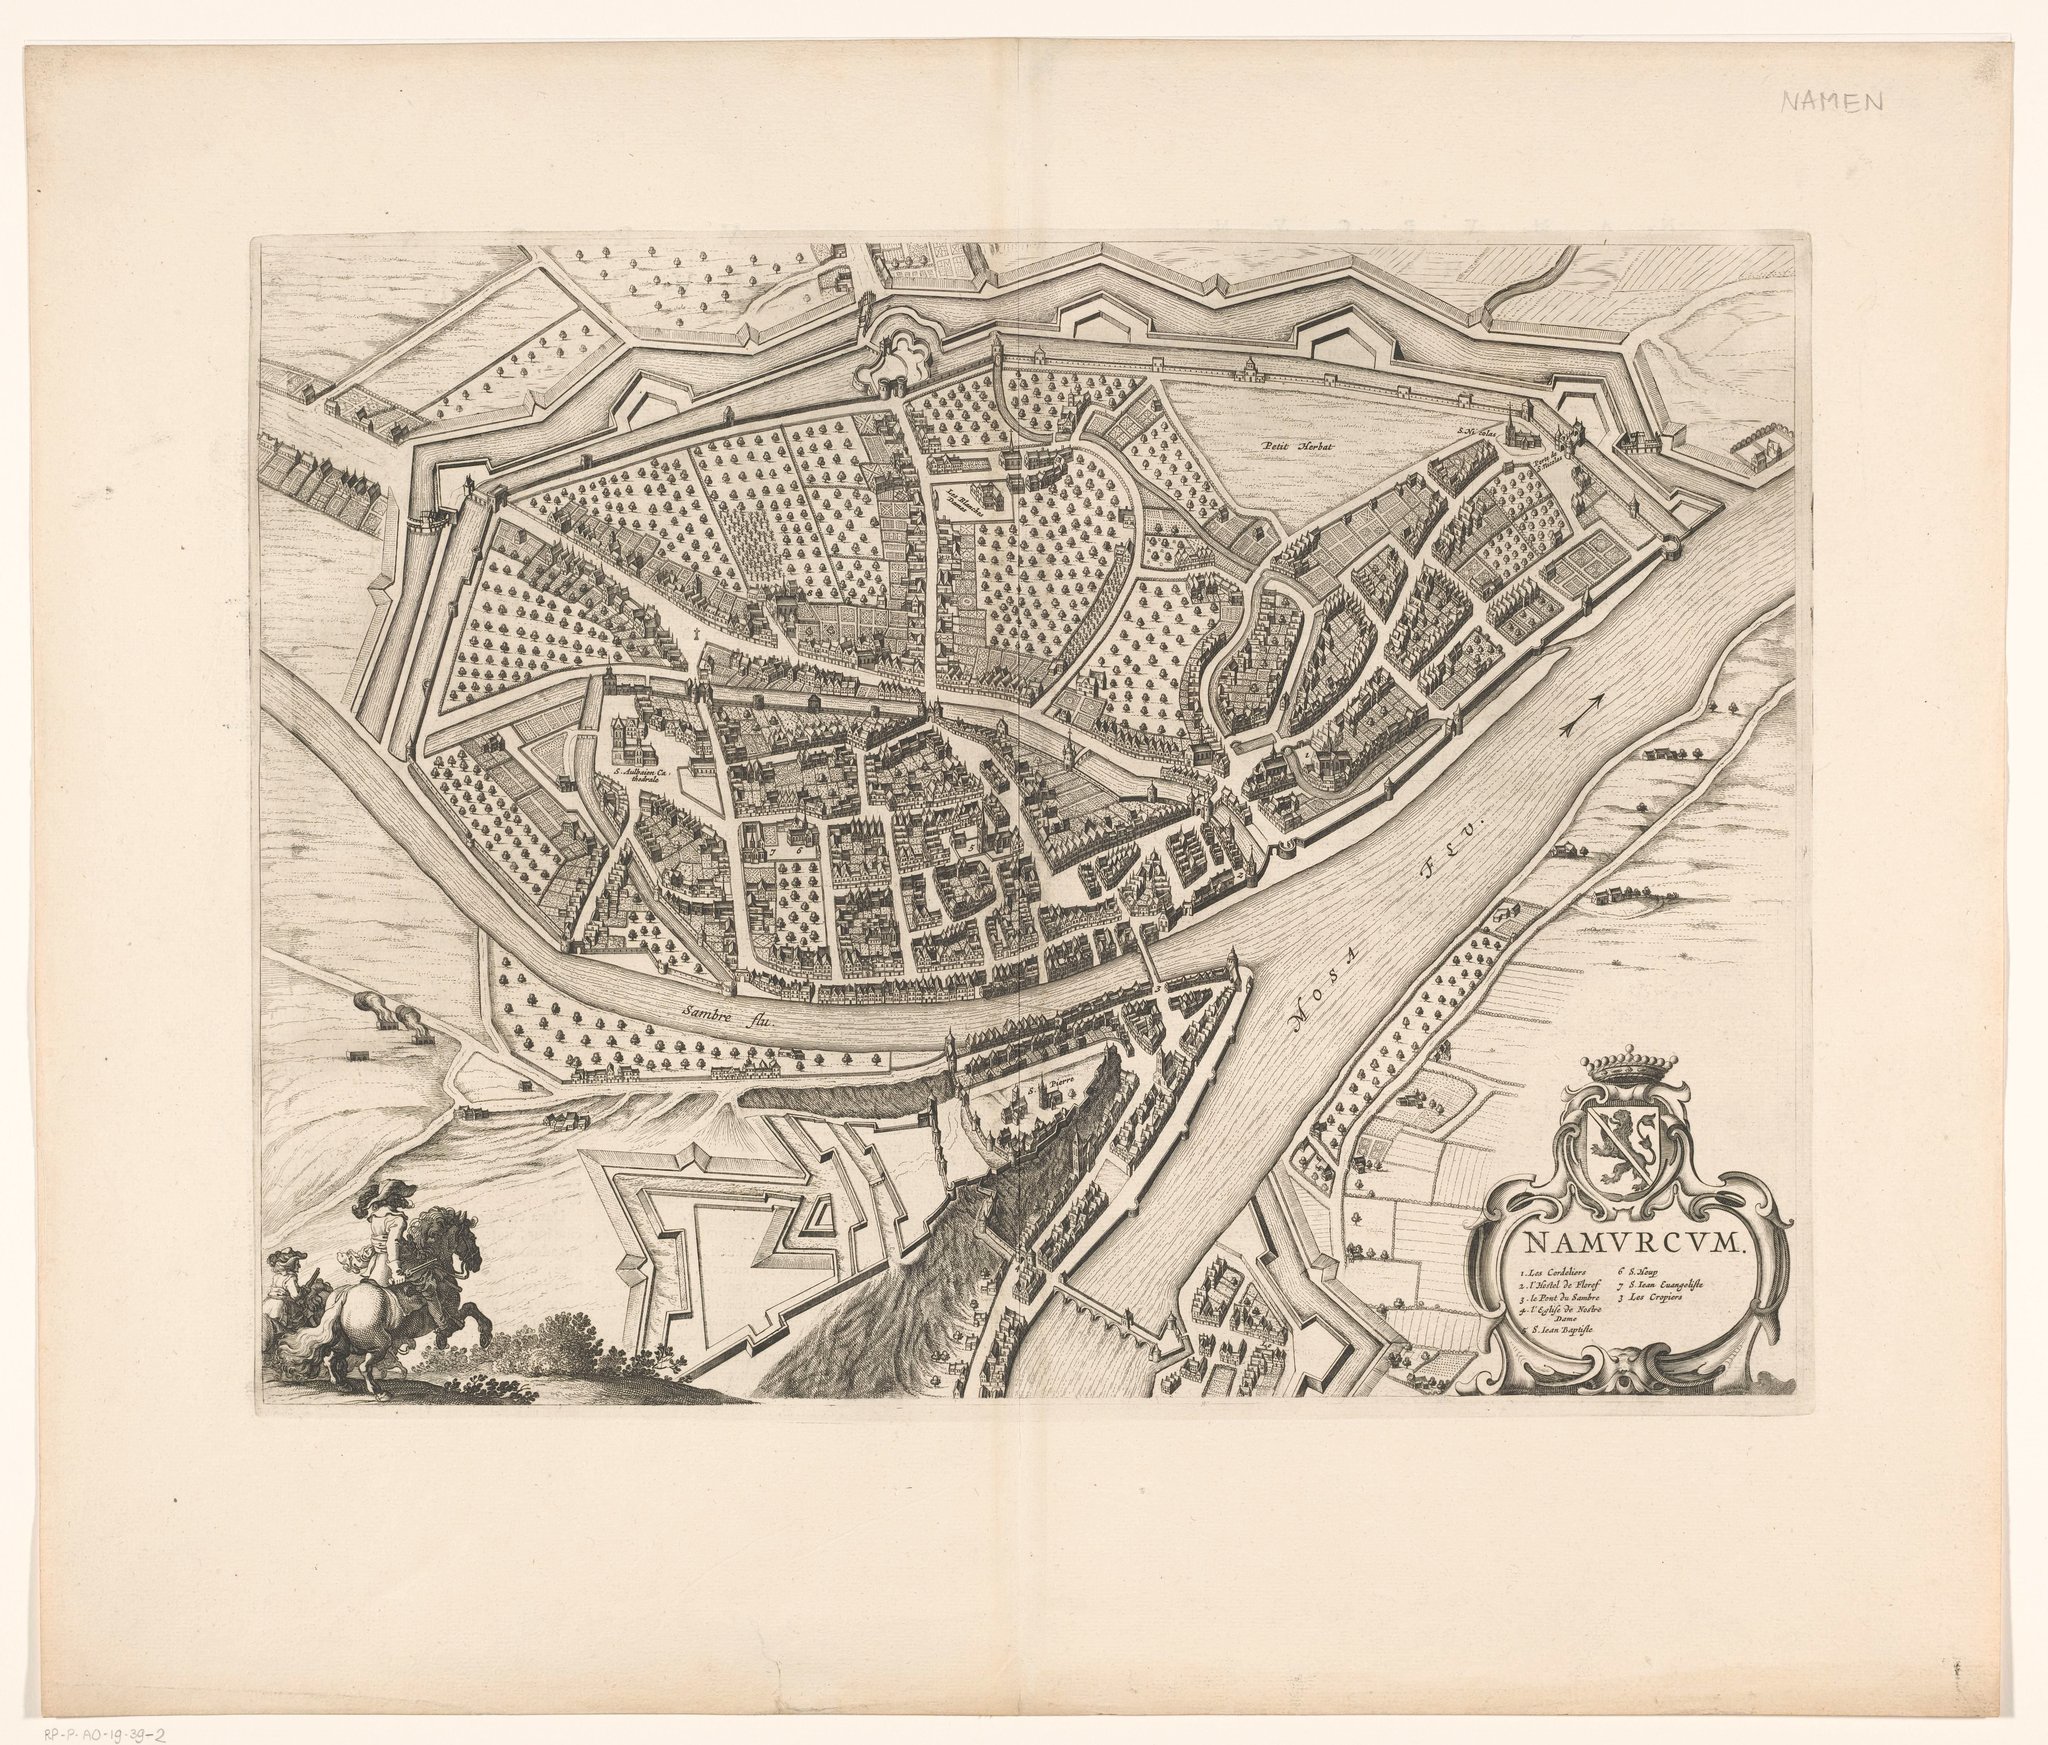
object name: area plan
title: Namurcum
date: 1652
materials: paper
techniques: engraving, etching, letterpress printing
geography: amsterdam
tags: fortified city, maps of cities, coat of arms (as symbol of the state, etc.) (+ province; provincial)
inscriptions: collector's mark: Lugt 2228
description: Plattegrond van Namen met gebouwen in vogelvluchtperspectief. Rechtsonder de titelcartouche met legenda 1-8, en het wapen van het graafschap Namen. Met Latijnse tekst op verso.